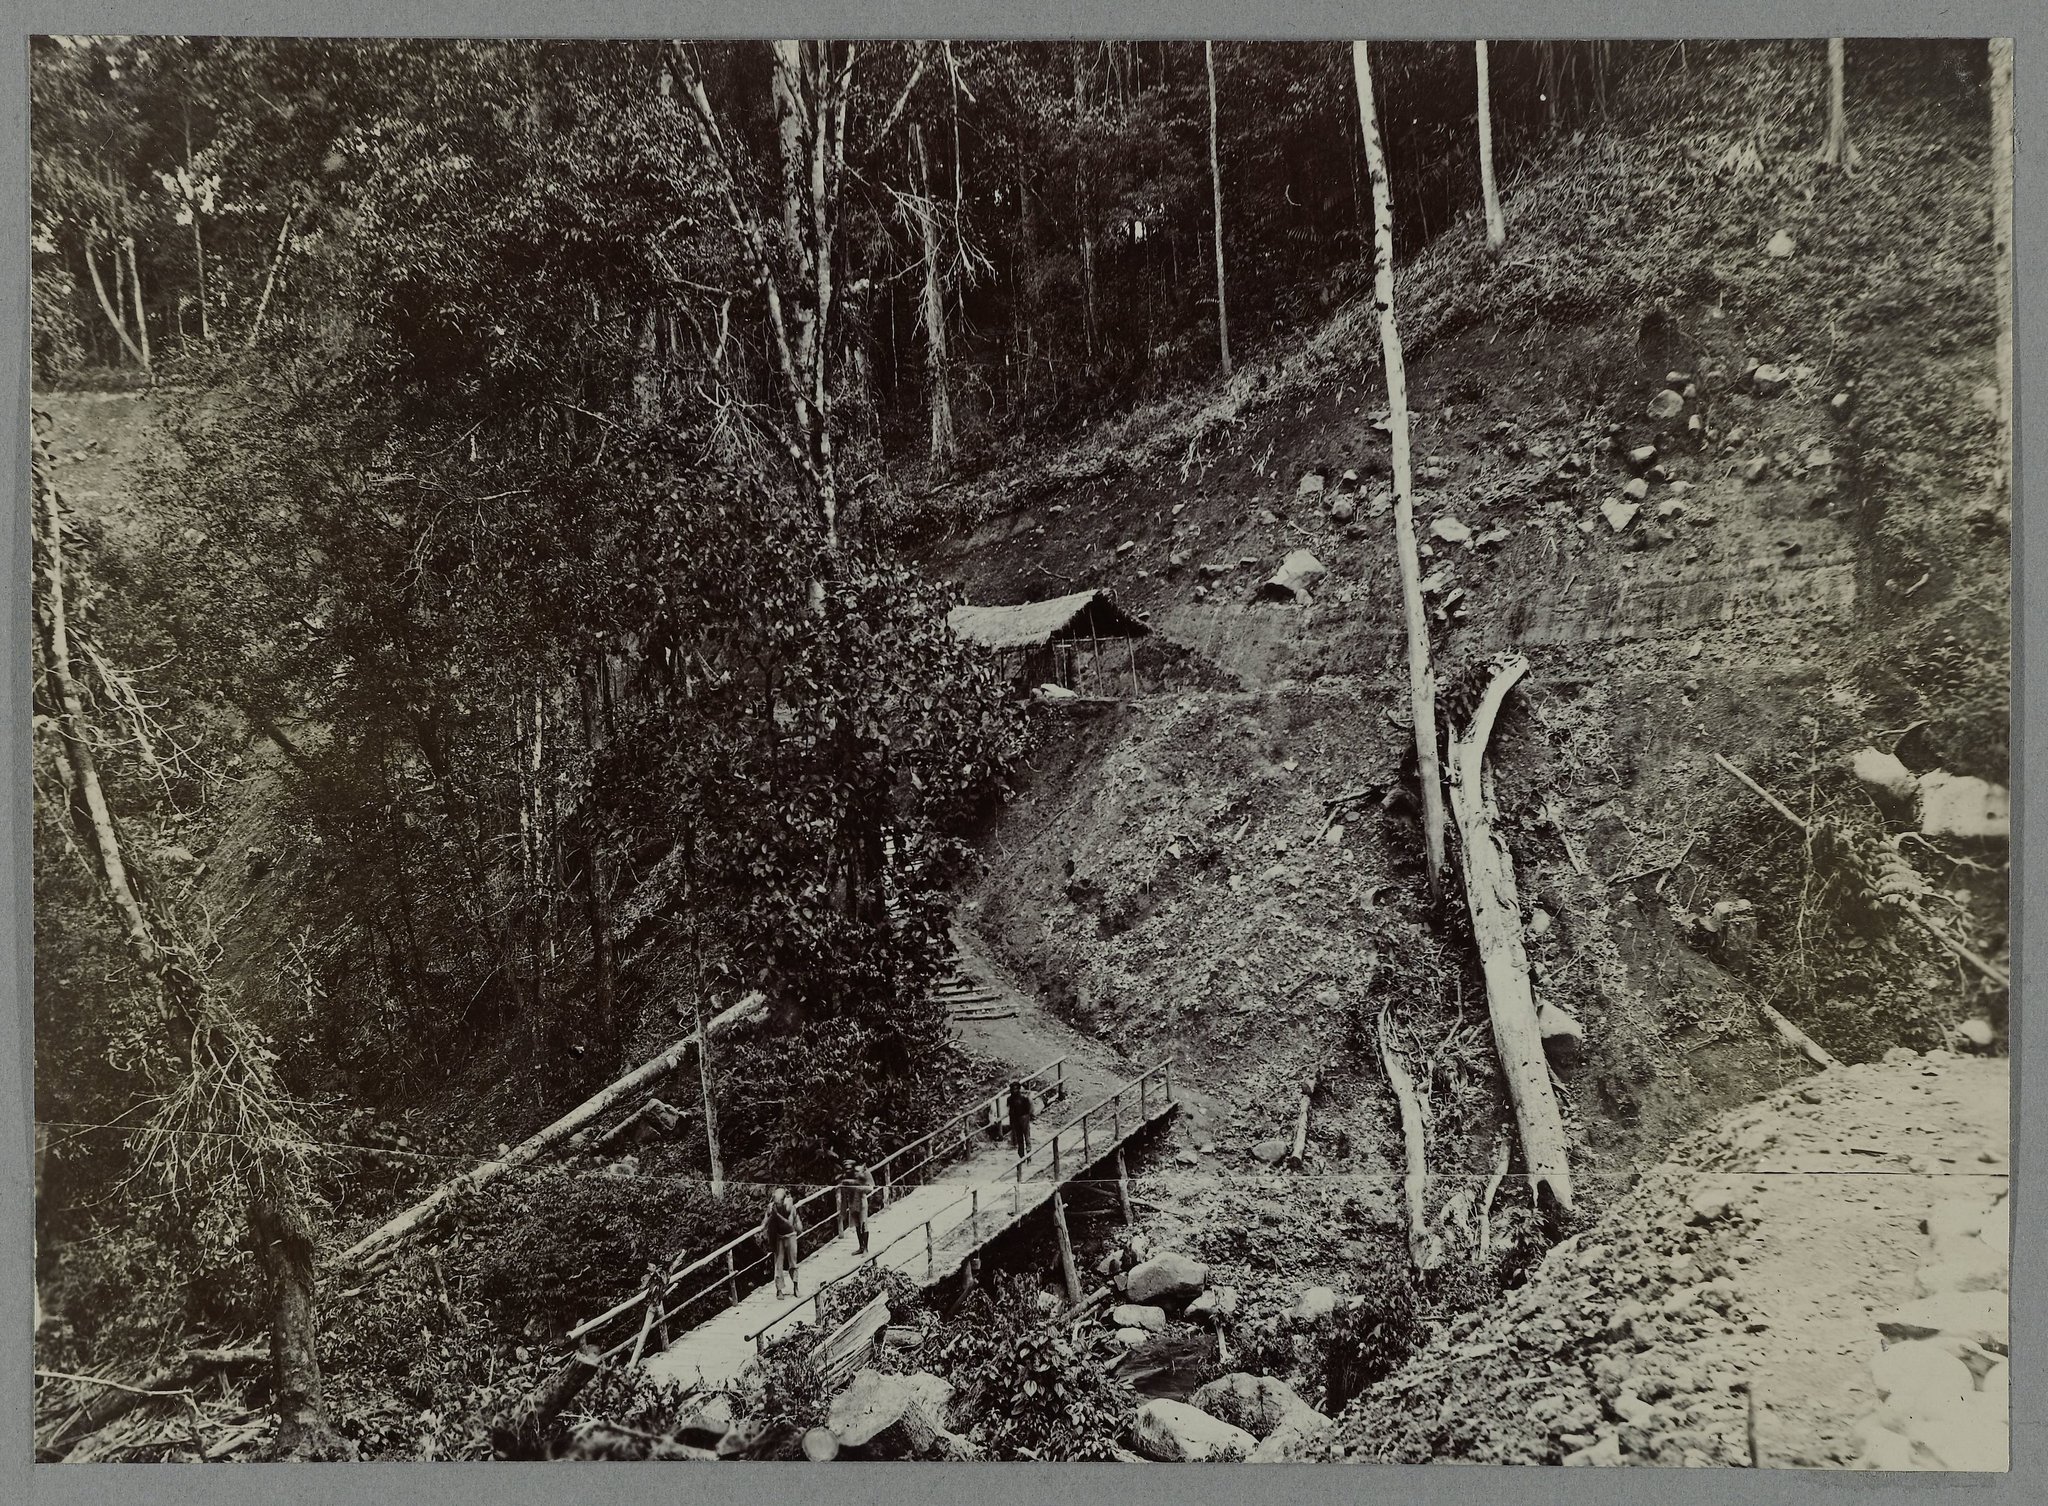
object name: photograph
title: Aanvang van de bouw van de brug over de Aroel Timbang Gadja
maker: Anonymous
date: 1903-1913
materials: photographic support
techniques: photography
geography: north sumatra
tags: arnhem, the hague, albertus dominicus laman trip, building activities, traffic by road or path with motor-vehicle, landscapes in tropical and sub-tropical regions, road, path, bridge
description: Na de expedities naar de Gajo- en Alaslanden o.l.v. Van Daalen (eerste tocht in 1901), werd hij in 1903 belast met voorbereiding van permanente vestiging van Nederlands gezag. Aanleg van een weg van de Noordkust naar het binnenland was hierbij van groot belang. Deze zgn. Gajoweg werd aangelegd tussen 1903 en 1914, van Bireuen aan de kust naar Takinguen aan het bergmeer Danau Lauttawar, totale lente 104 km.